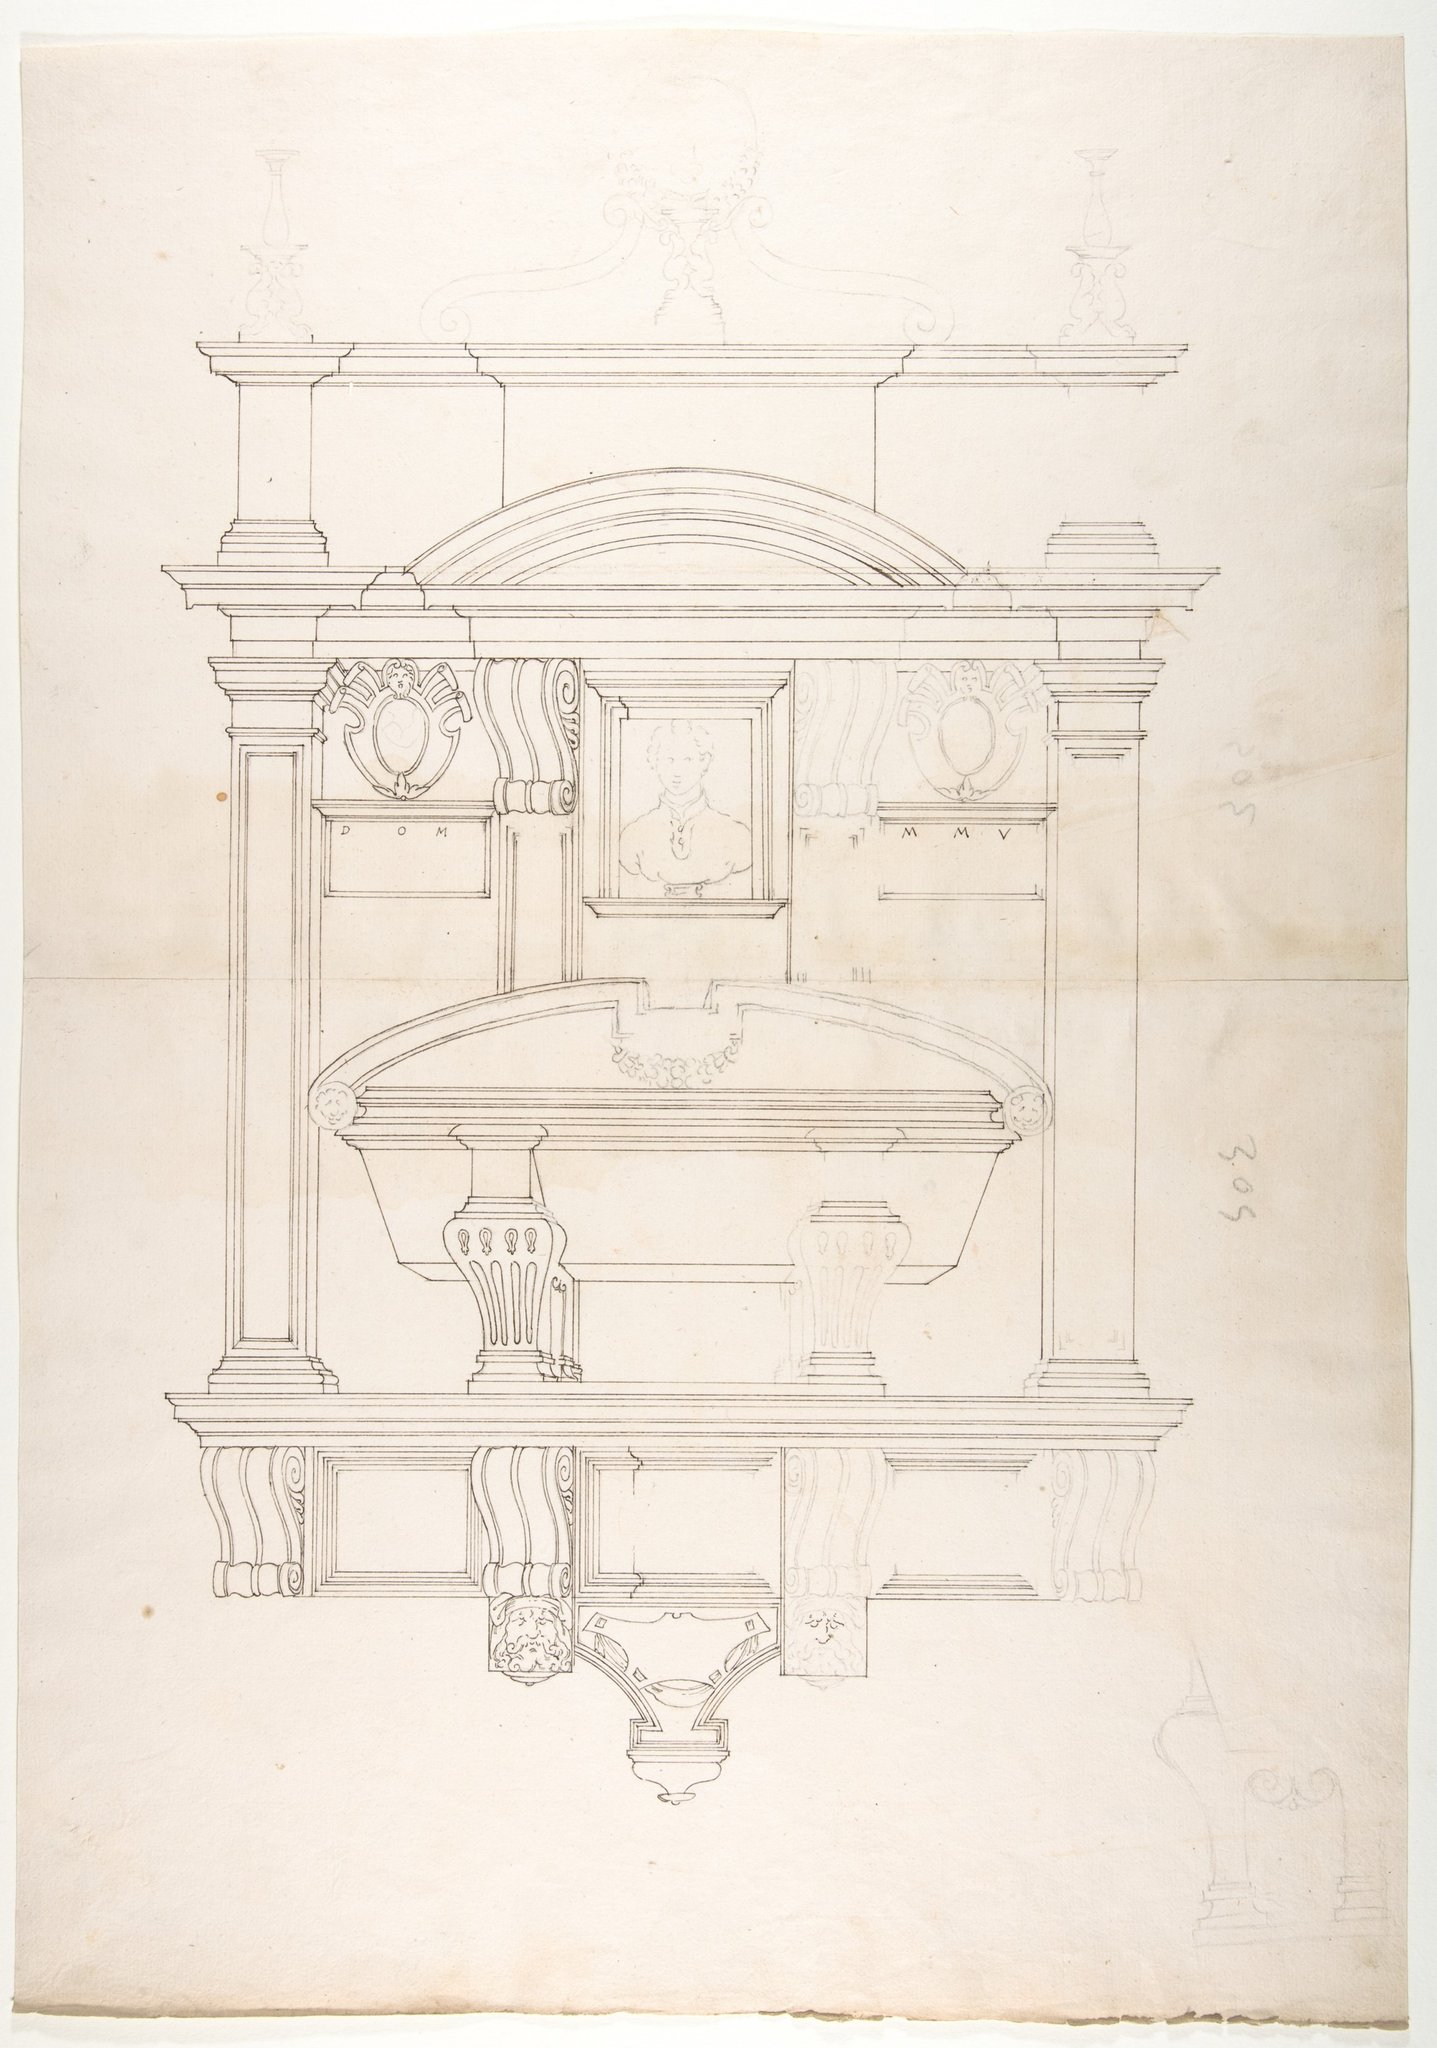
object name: drawing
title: Tomb of Cecchino Bracci, S. Maria in Araceoli, Rome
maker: anonymous, french, 16th century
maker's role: artist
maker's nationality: french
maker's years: 1500-1600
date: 1501-1600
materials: chalk, ink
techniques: pen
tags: architecture,tombs